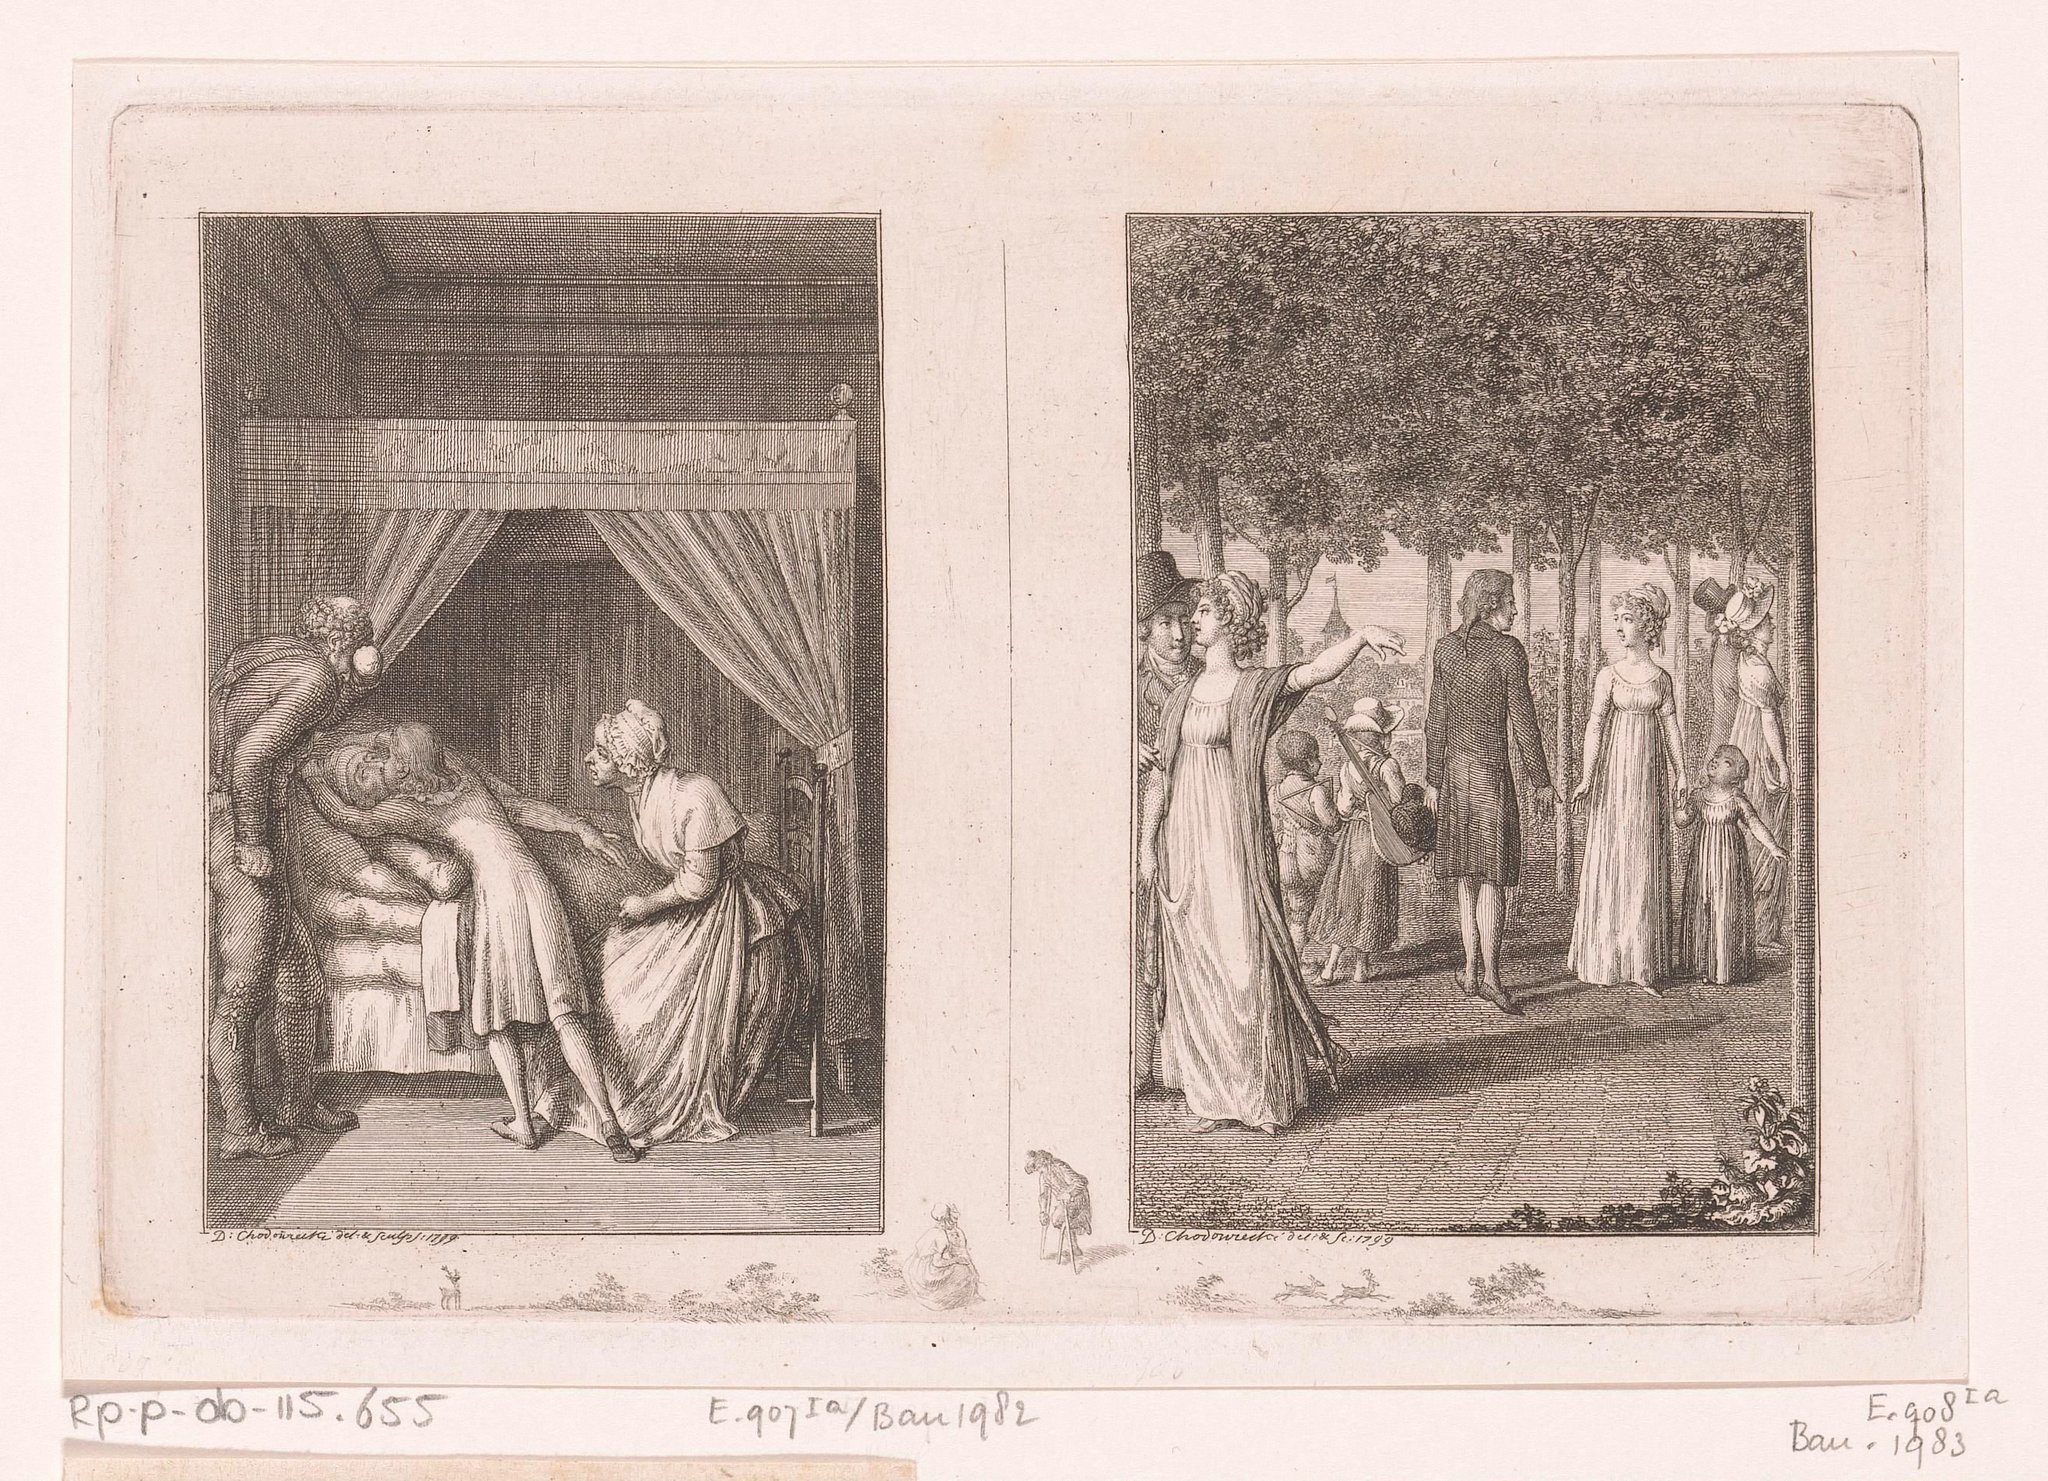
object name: print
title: Twee voorstellingen uit Herrmann Lange van August Lafontaine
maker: daniel nikolaus chodowiecki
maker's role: draughtsman, print maker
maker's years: 1726-1801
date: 1799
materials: paper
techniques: etching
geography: berlin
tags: deathbed, embracing each other, kissing, picnic, alfresco, 'déjeuner sur l'herbe', conversation, dialogue; conversation piece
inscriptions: collector's mark: Lugt 2228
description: Prenten gebruikt voor: Lang, Karl. Taschenbuch für Häusliche und gesellschaftliche Freuden. Frankfurt am Main: Philipp Heinrich Guilhaumain, [1799].